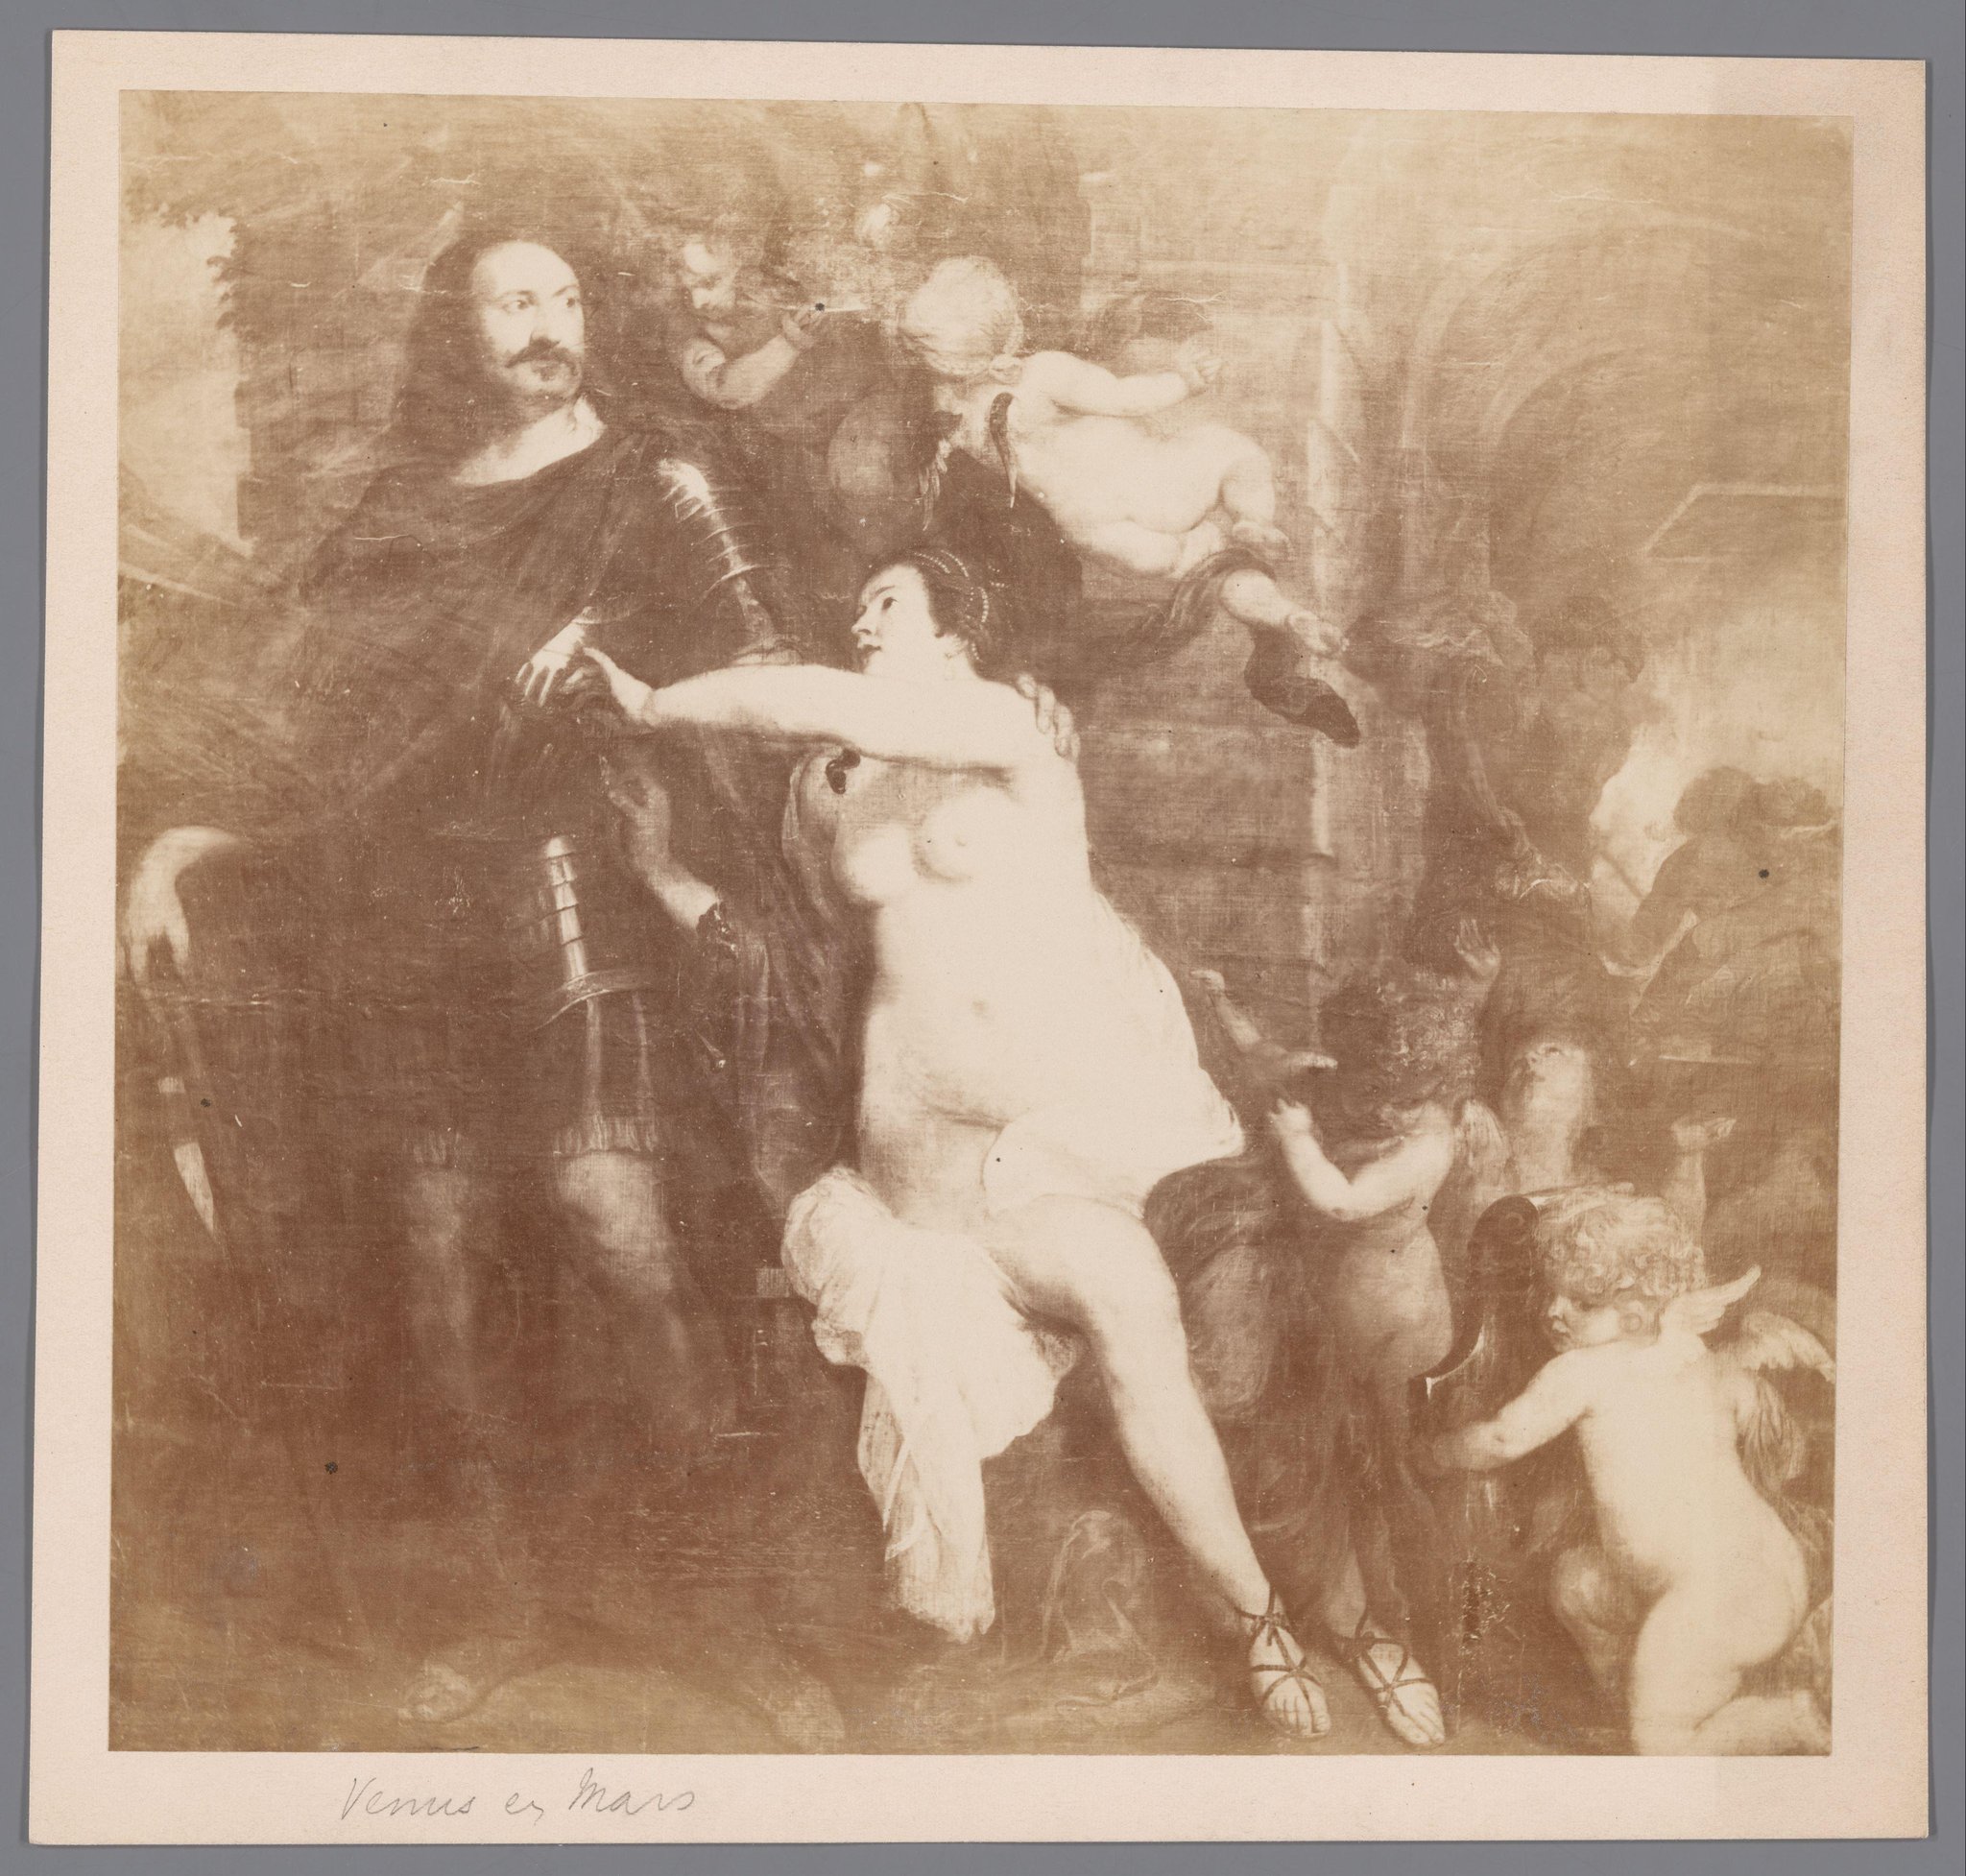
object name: photograph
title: Fotoreproductie van het schilderij Mars ontvangt de wapens van Venus en Vulcanus door Thomas Willeboirts Bosschaert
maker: Anonymous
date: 1885-1900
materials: cardboard, paper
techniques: albumen print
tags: frederik willem van brandenburg (i), the hague, louise henriëtte (prinses van oranje), picture, painting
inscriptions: inscription: ‘Venus en Mars’, inscription: ‘Thomas Willeboirts 1633’, number: ‘105’, inscription: ‘[...]’, collector's mark: Lugt 2228a